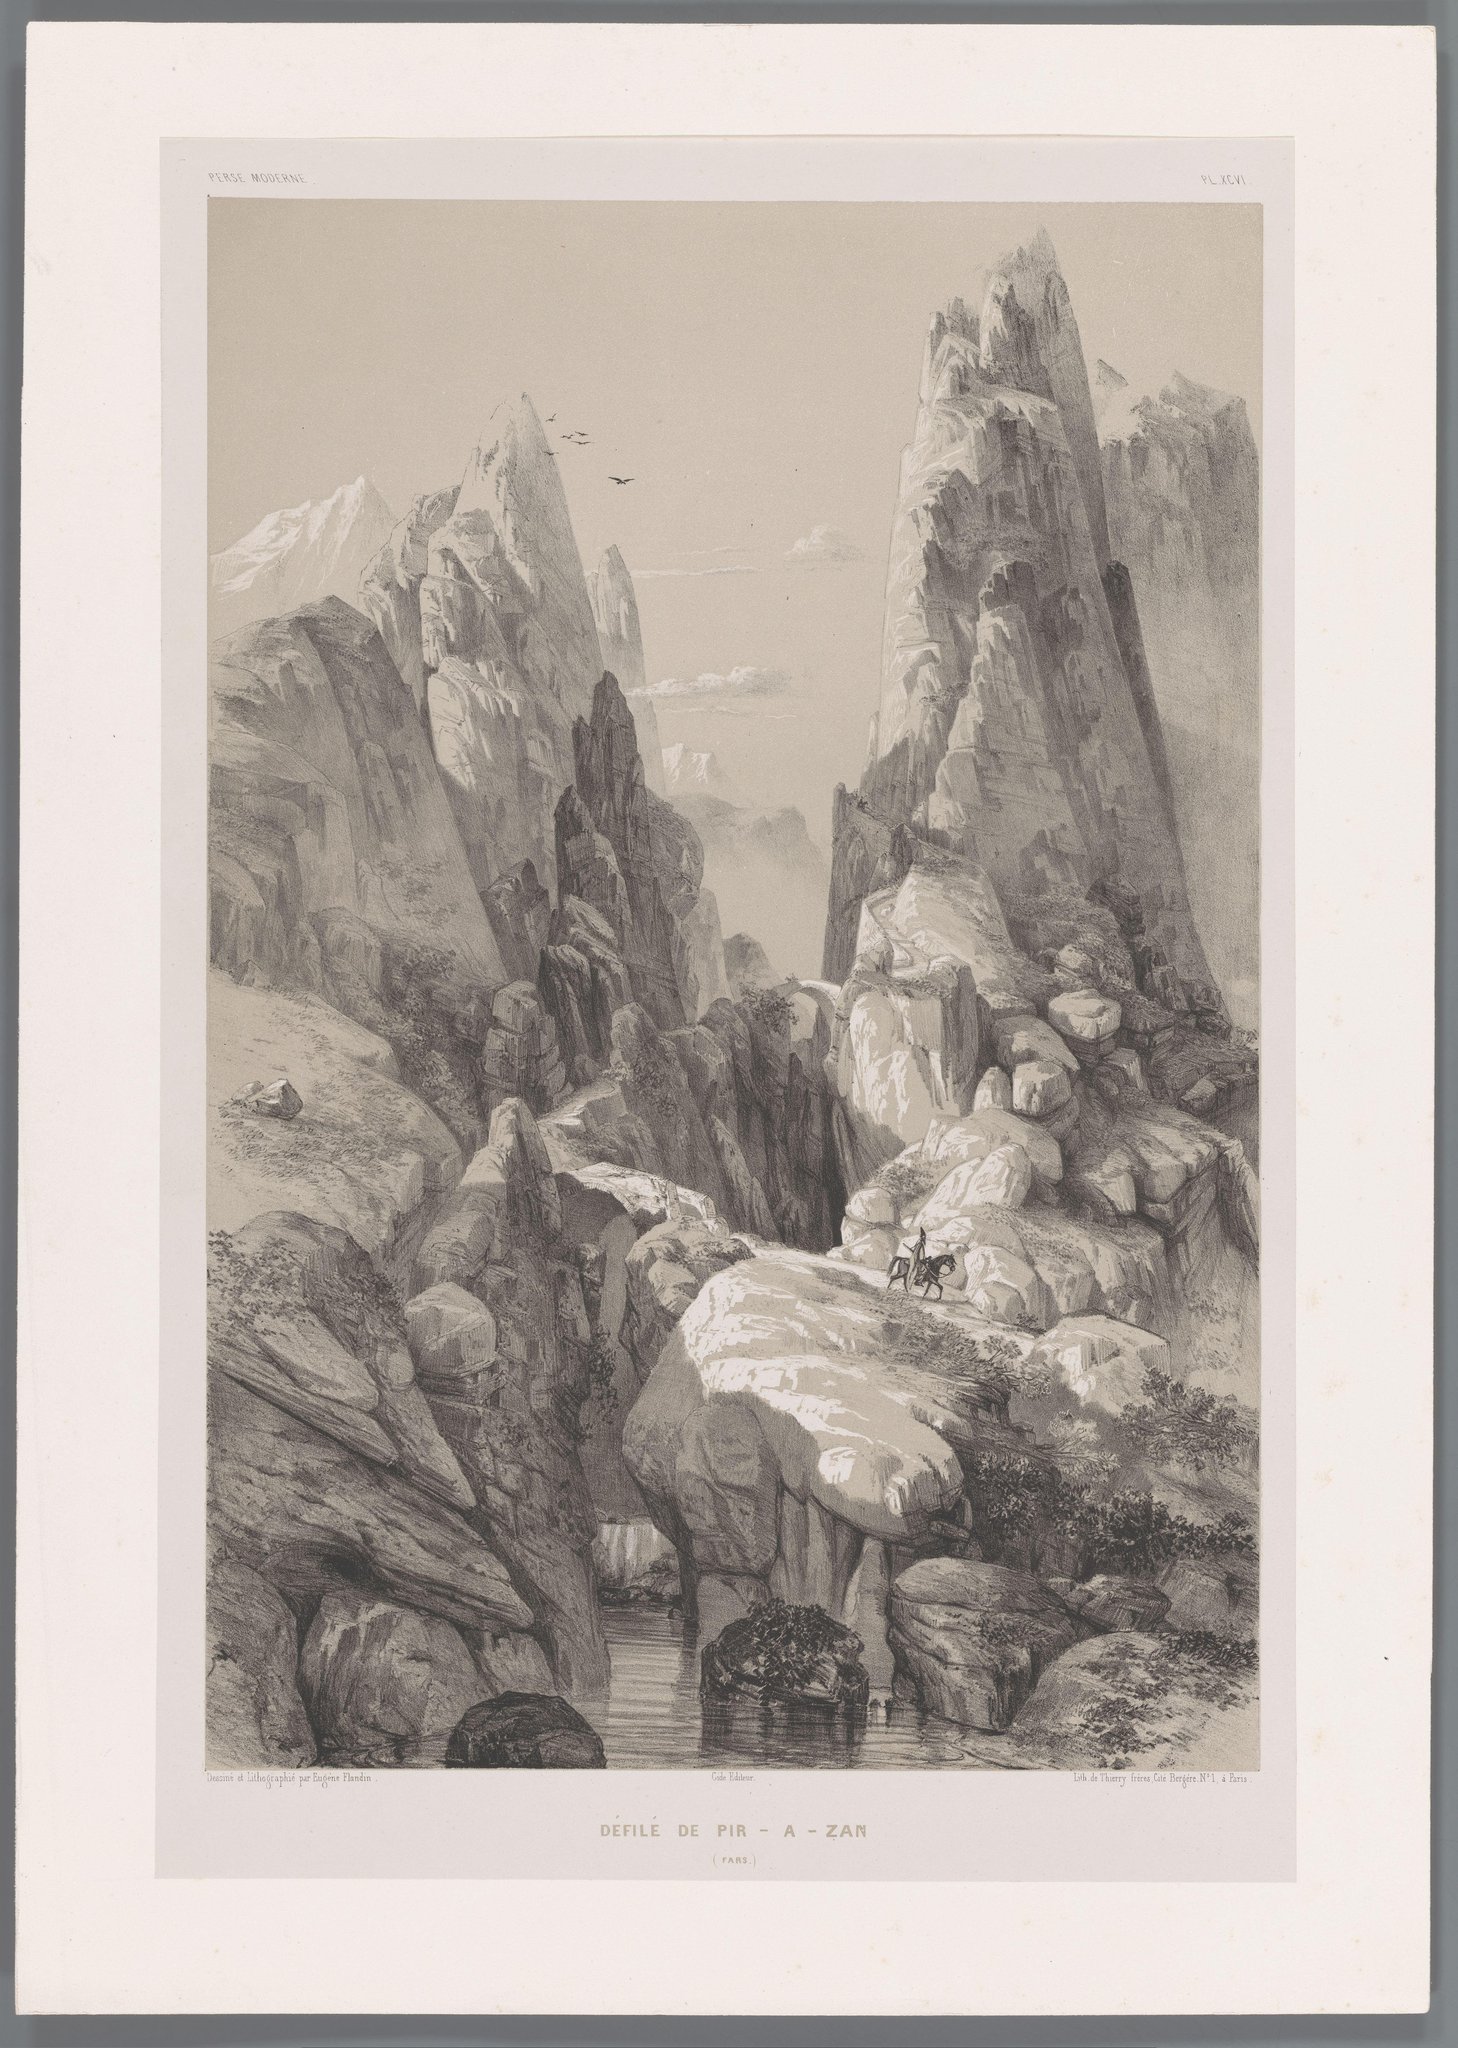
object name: book illustration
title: Perse moderne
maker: eugène flandin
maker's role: painter, print maker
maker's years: 1809-1889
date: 1843-1854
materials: paper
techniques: tone lithography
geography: paris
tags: mountain-range, snow peaks (+ landscape with figures, staffage), ravine, chasm, abyss, canyon (+ landscape with figures, staffage)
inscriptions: collector's mark: Lugt 2228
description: Een bergpad kronkelt over een brug die het ravijn overspant. Op het pad enkele ruiters. Onderin het ravijn stroomt een rivier. Links boven de afbeelding de serietitel, rechtsboven het plaatnummer "Pl. XCVI".